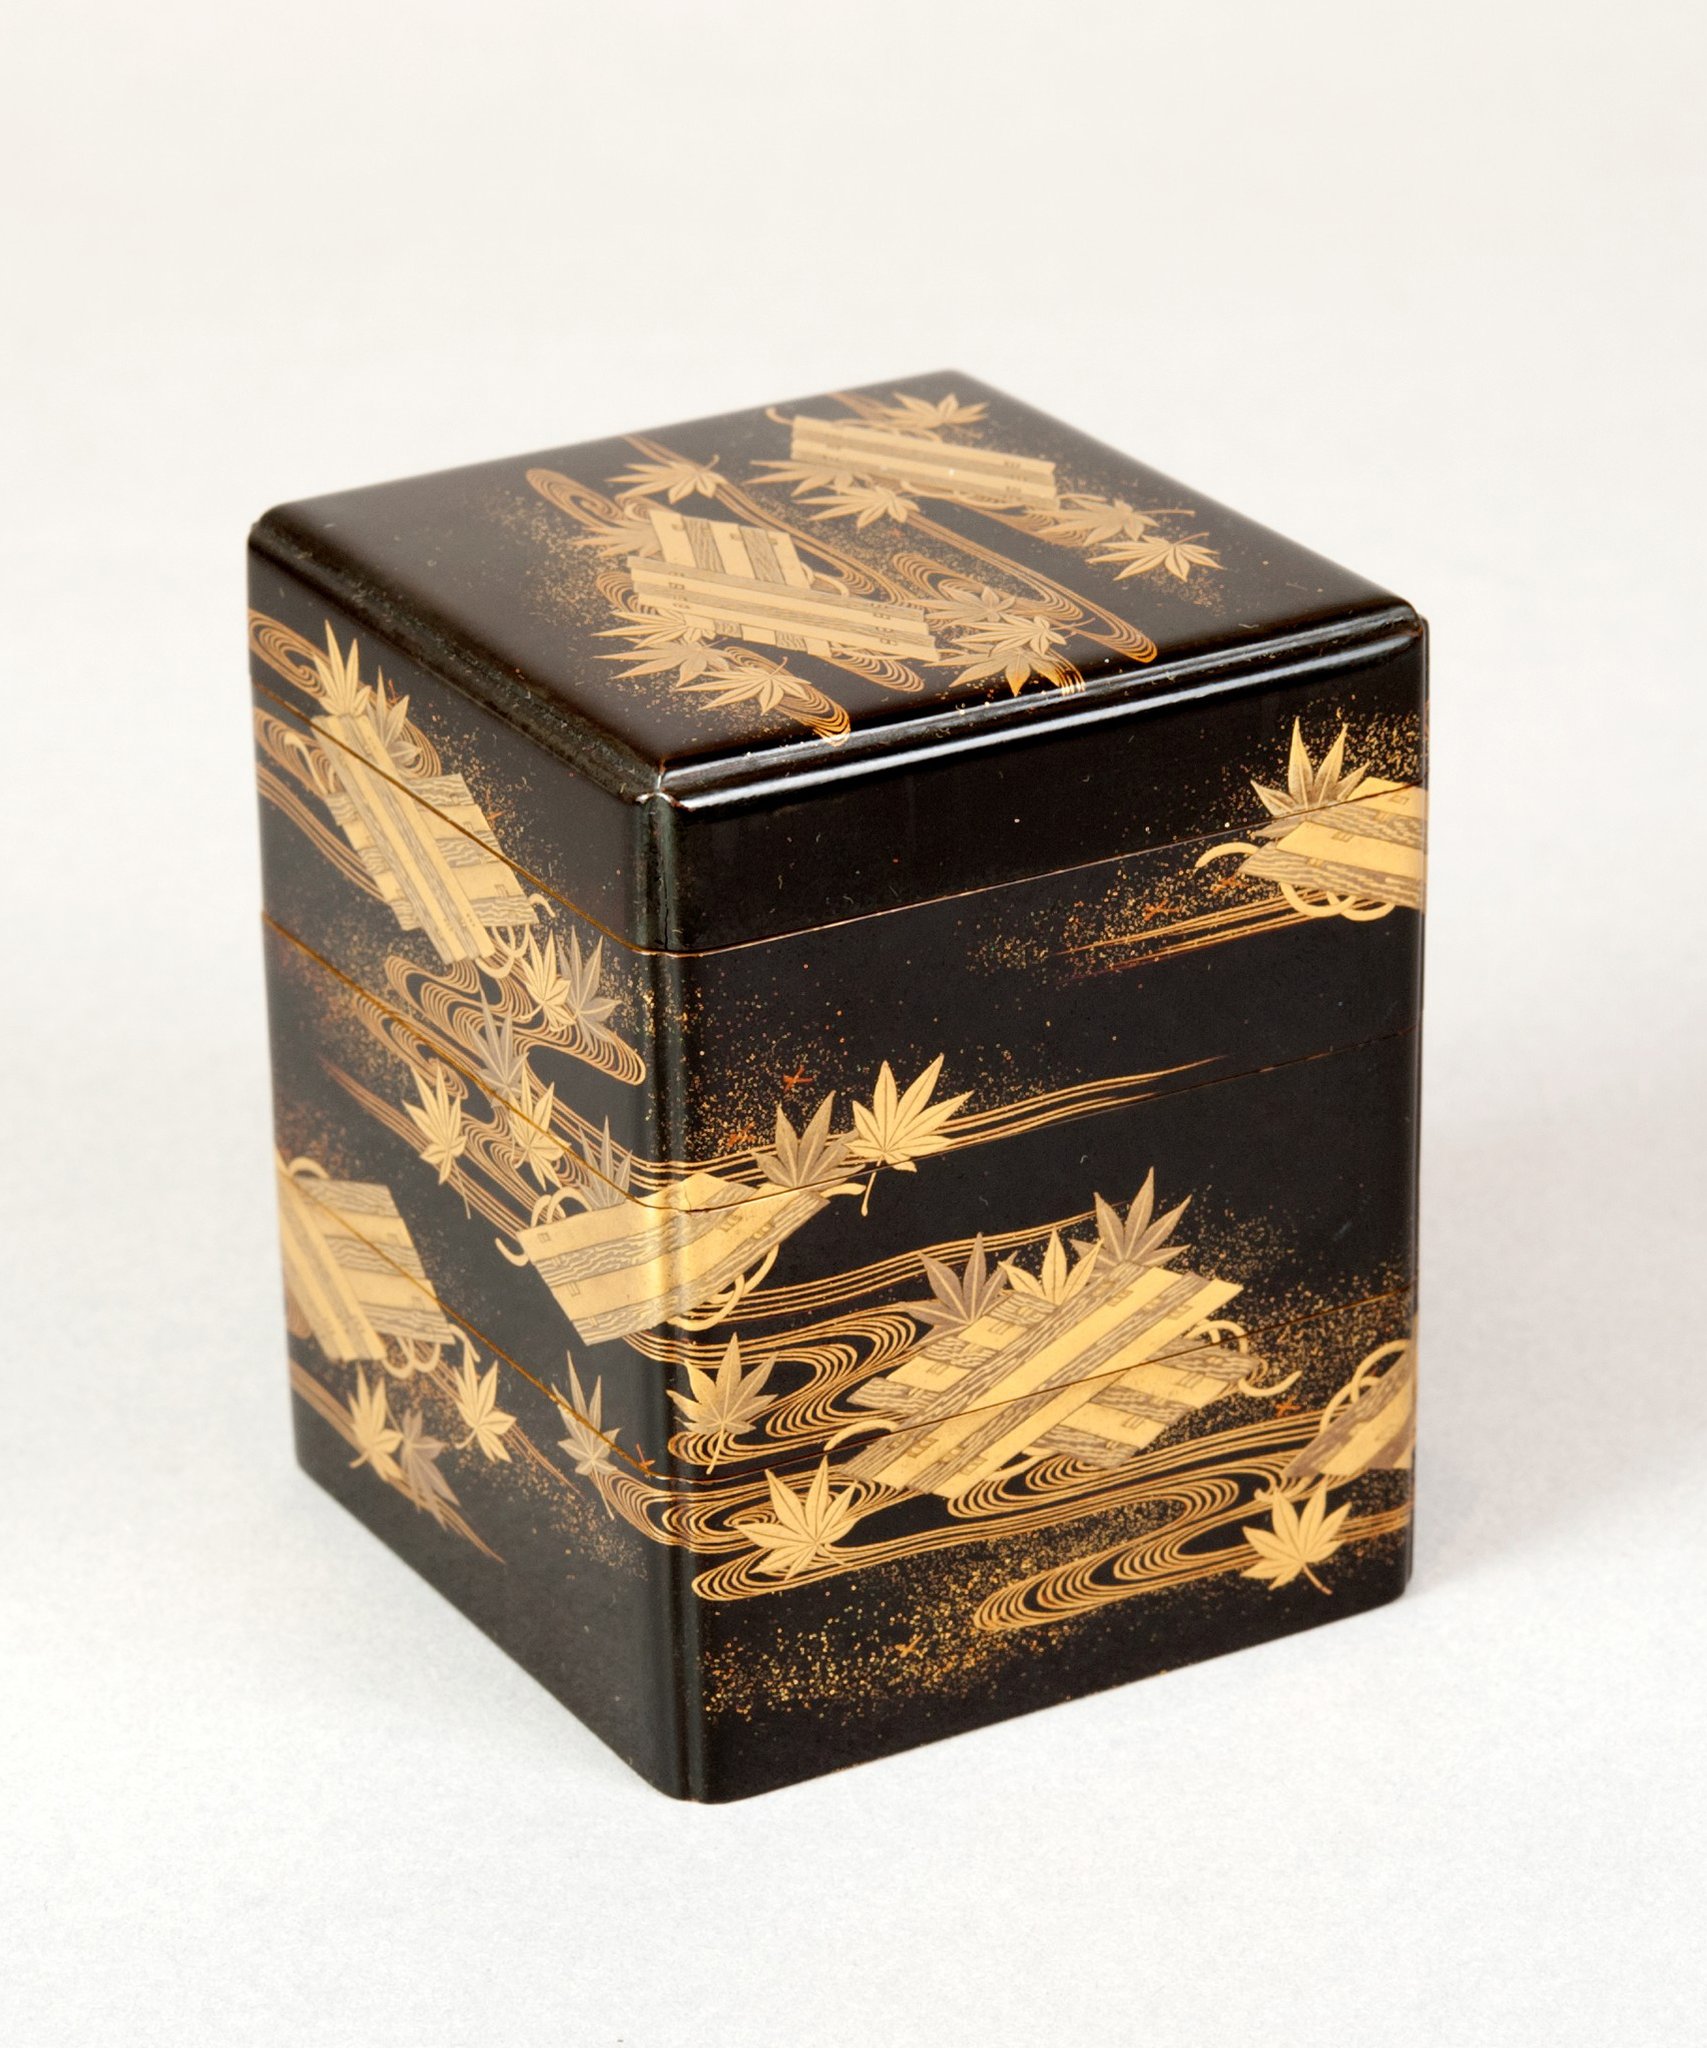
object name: tiered box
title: Tiered Box with Design of Maple and Raft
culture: japanese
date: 1701-1800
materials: gold, lacquer, silver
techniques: maki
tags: leaves